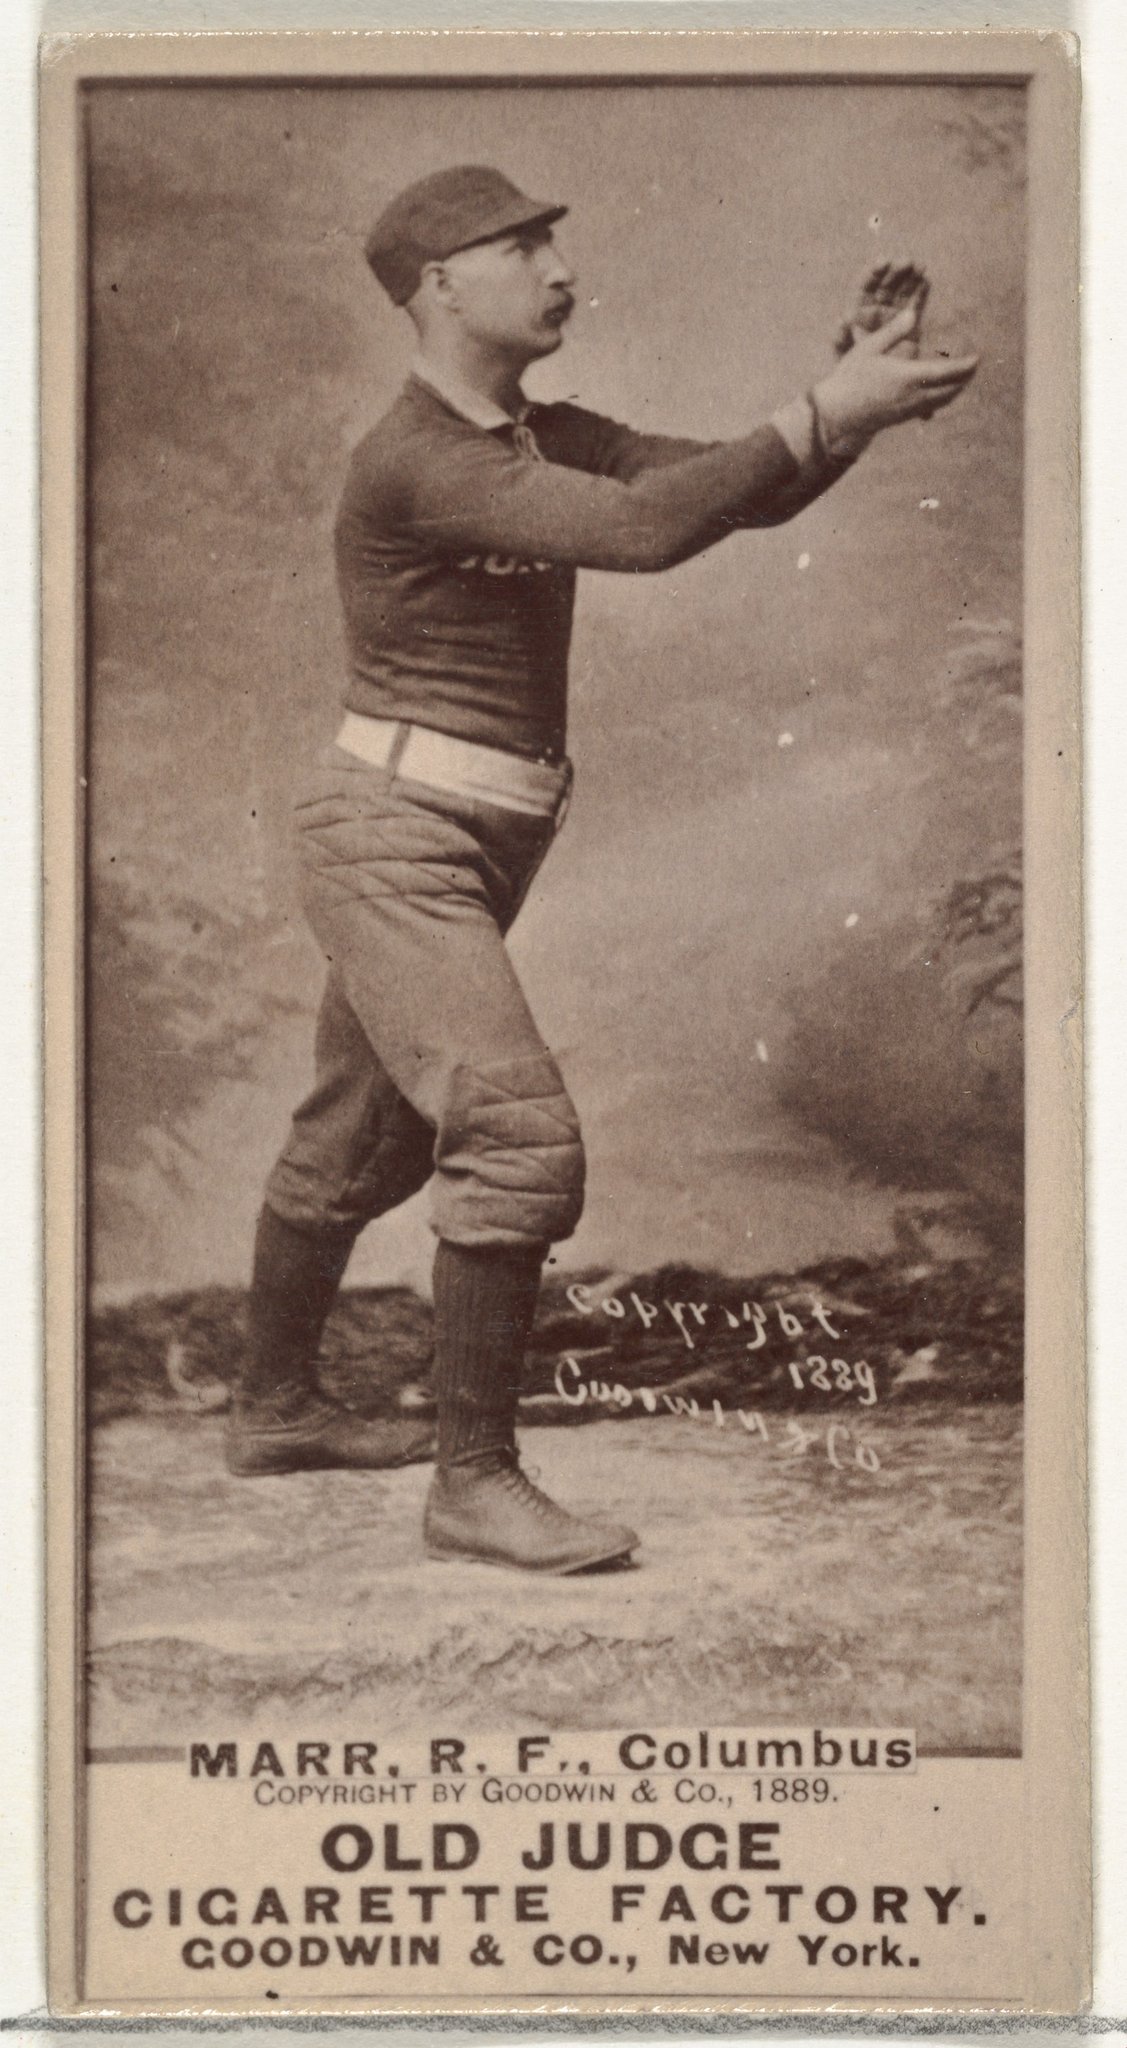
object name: baseball card, photograph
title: Charles W. "Lefty" Marr, Right Field, Cleveland, from the Old Judge series (N172) for Old Judge Cigarettes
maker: goodwin & company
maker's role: publisher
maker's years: 1850-1950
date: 1889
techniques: albumen silver print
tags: men,profiles,baseball,athletes